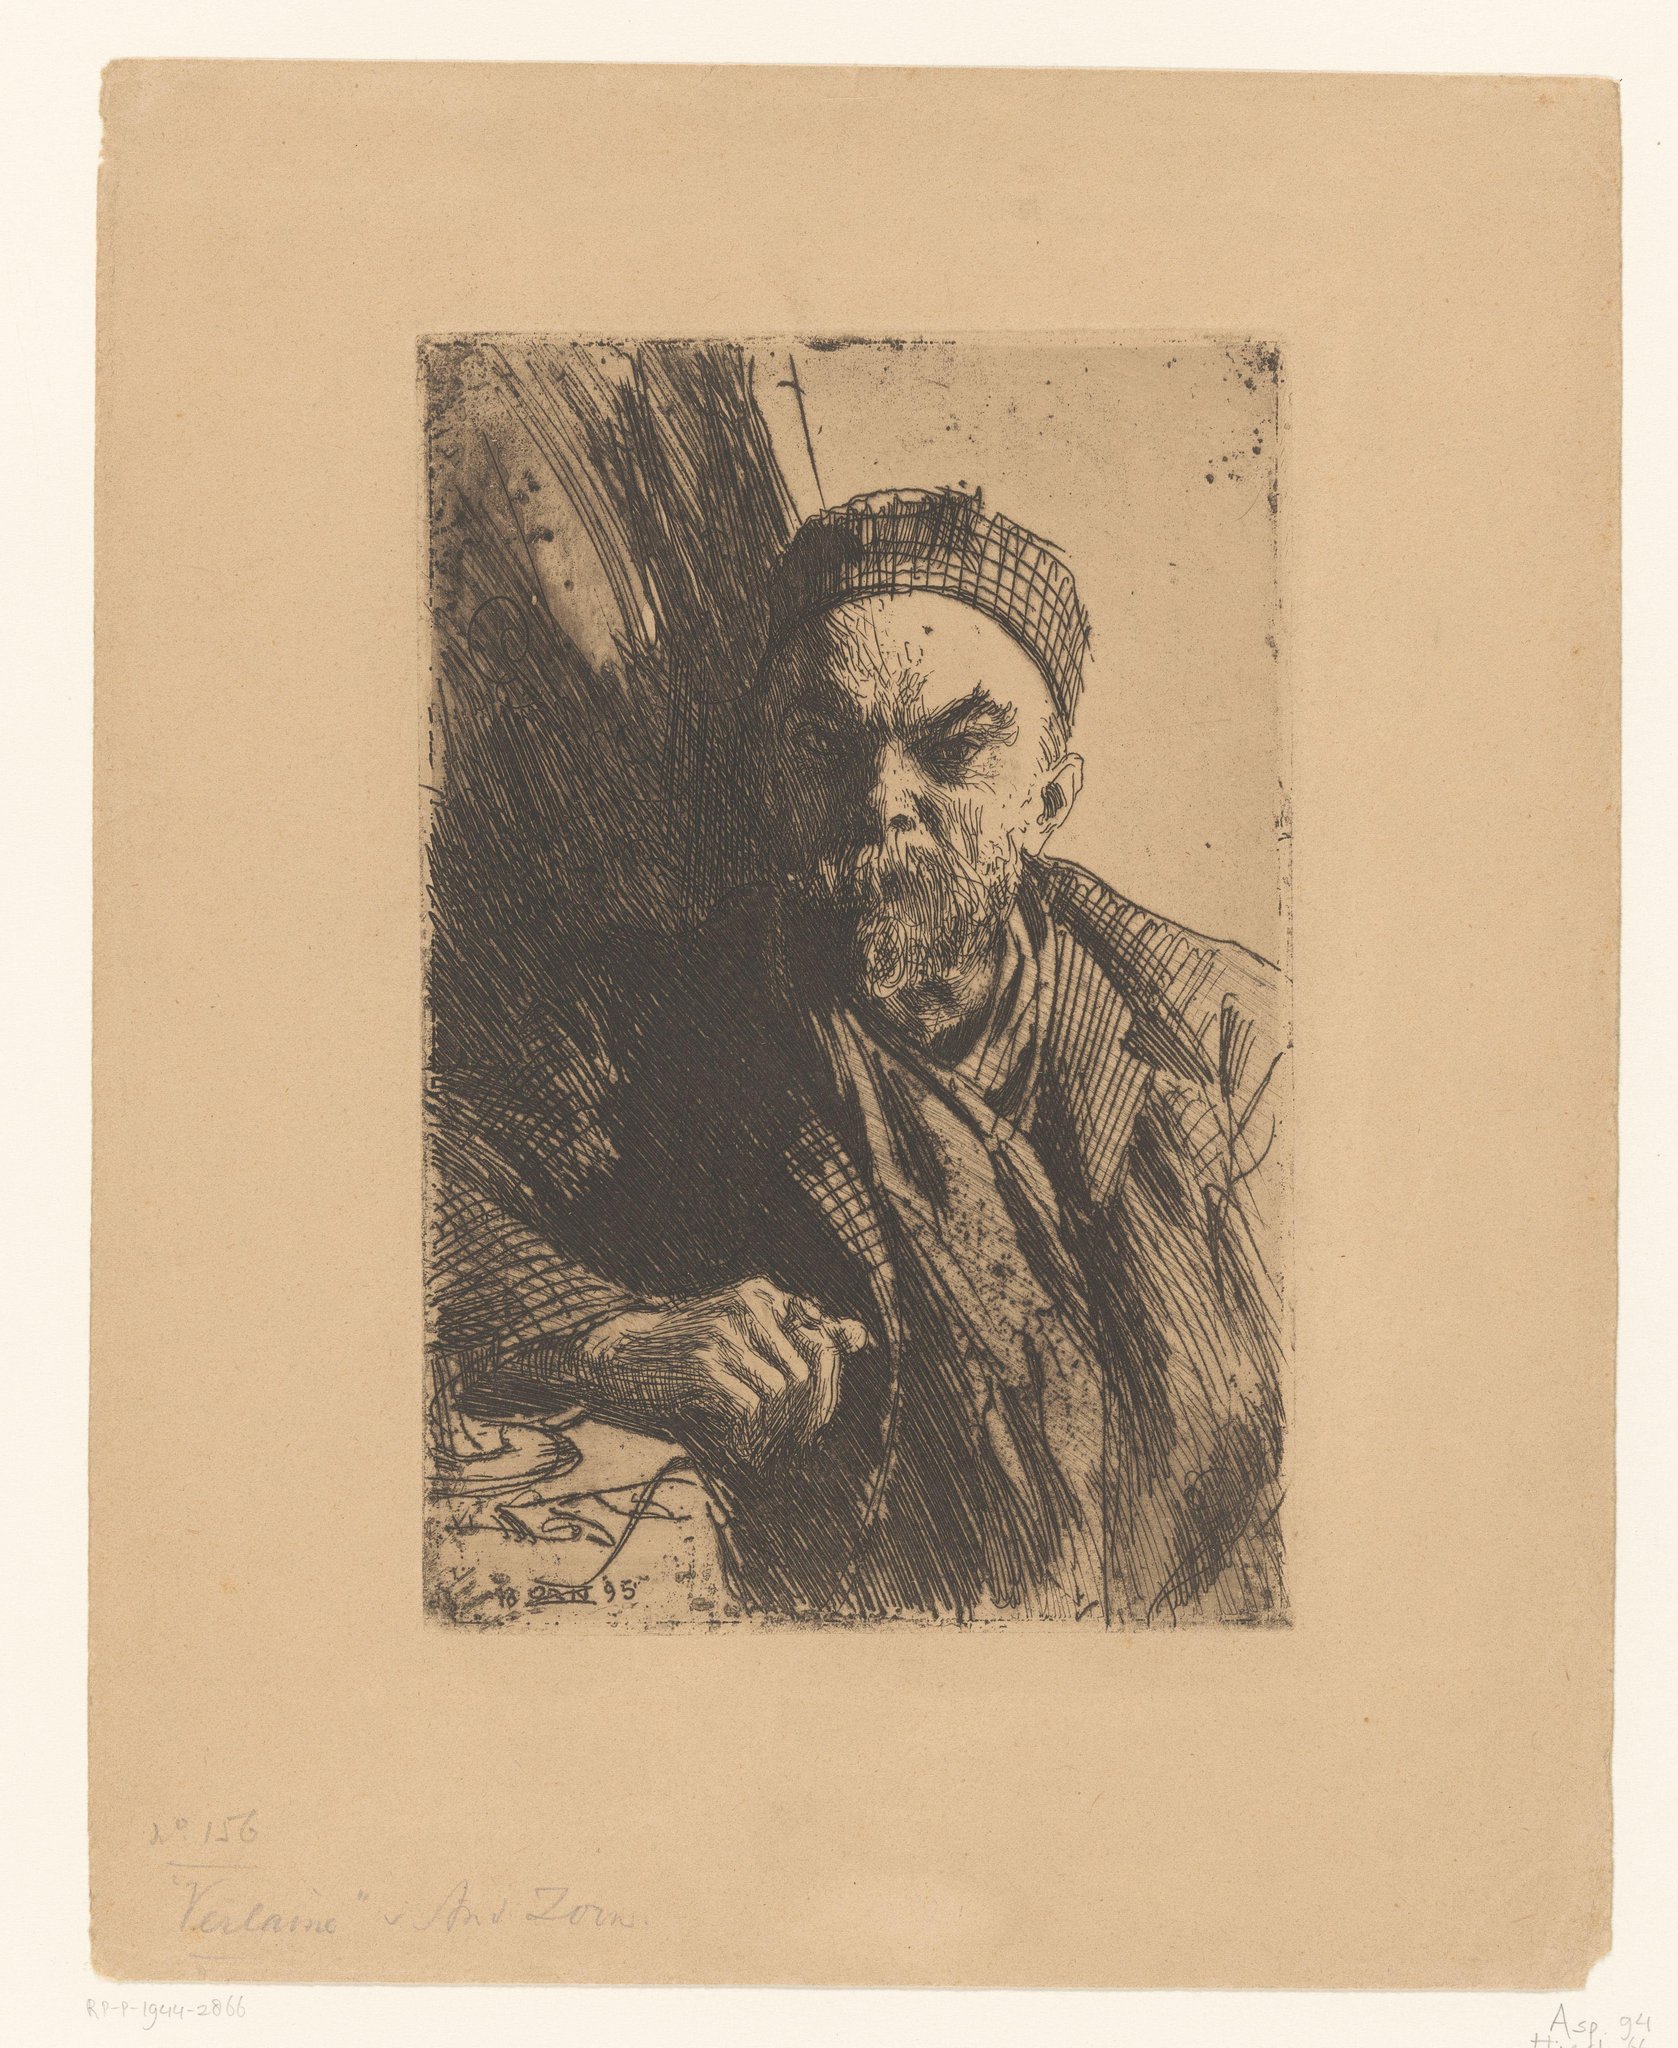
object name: print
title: Paul Verlaine II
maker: anders leonard zorn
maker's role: print maker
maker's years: 1860-1920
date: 1895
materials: paper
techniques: etching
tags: paris, paul verlaine, historical persons, portrait of a writer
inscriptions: collector's mark: Lugt 2228, collector's mark: Lugt 2760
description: Portret van de Frans dichter Paul Verlaine, tweede versie.